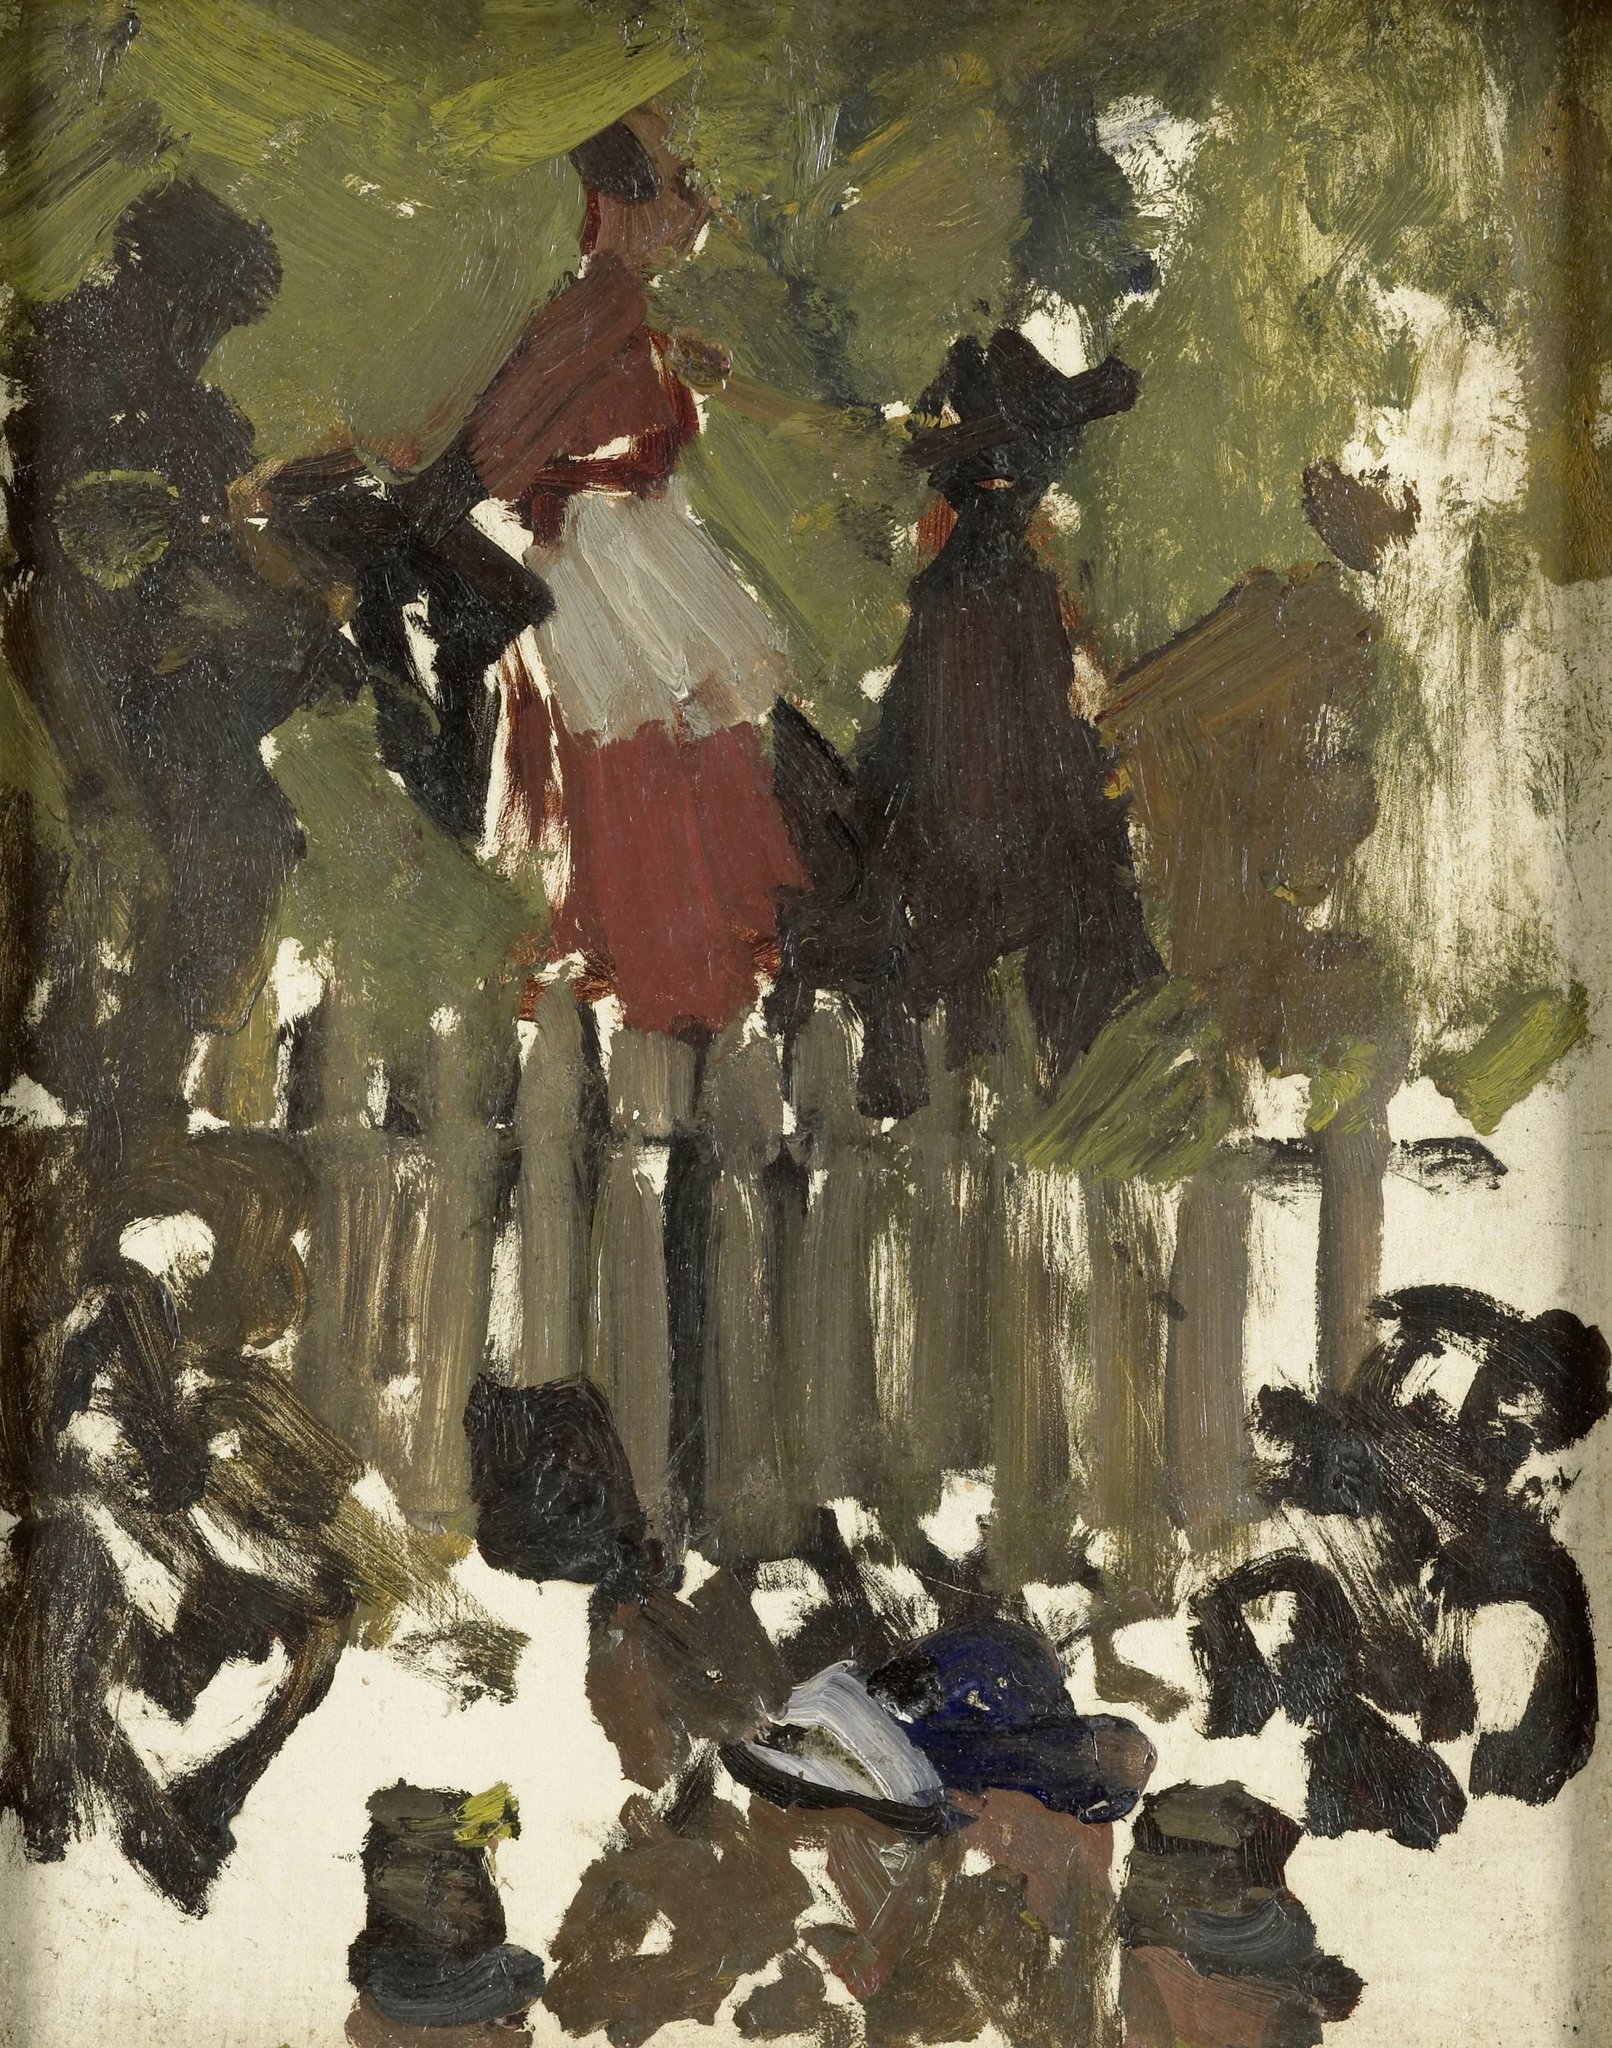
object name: painting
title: The Funfair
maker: george hendrik breitner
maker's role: draughtsman, painter, print maker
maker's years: 1857-1923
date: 1880-1923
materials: oil, panel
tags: merry-go-round, roundabout; chair o'plane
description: Kermisstudie. Vrouwen op een draaimolen?